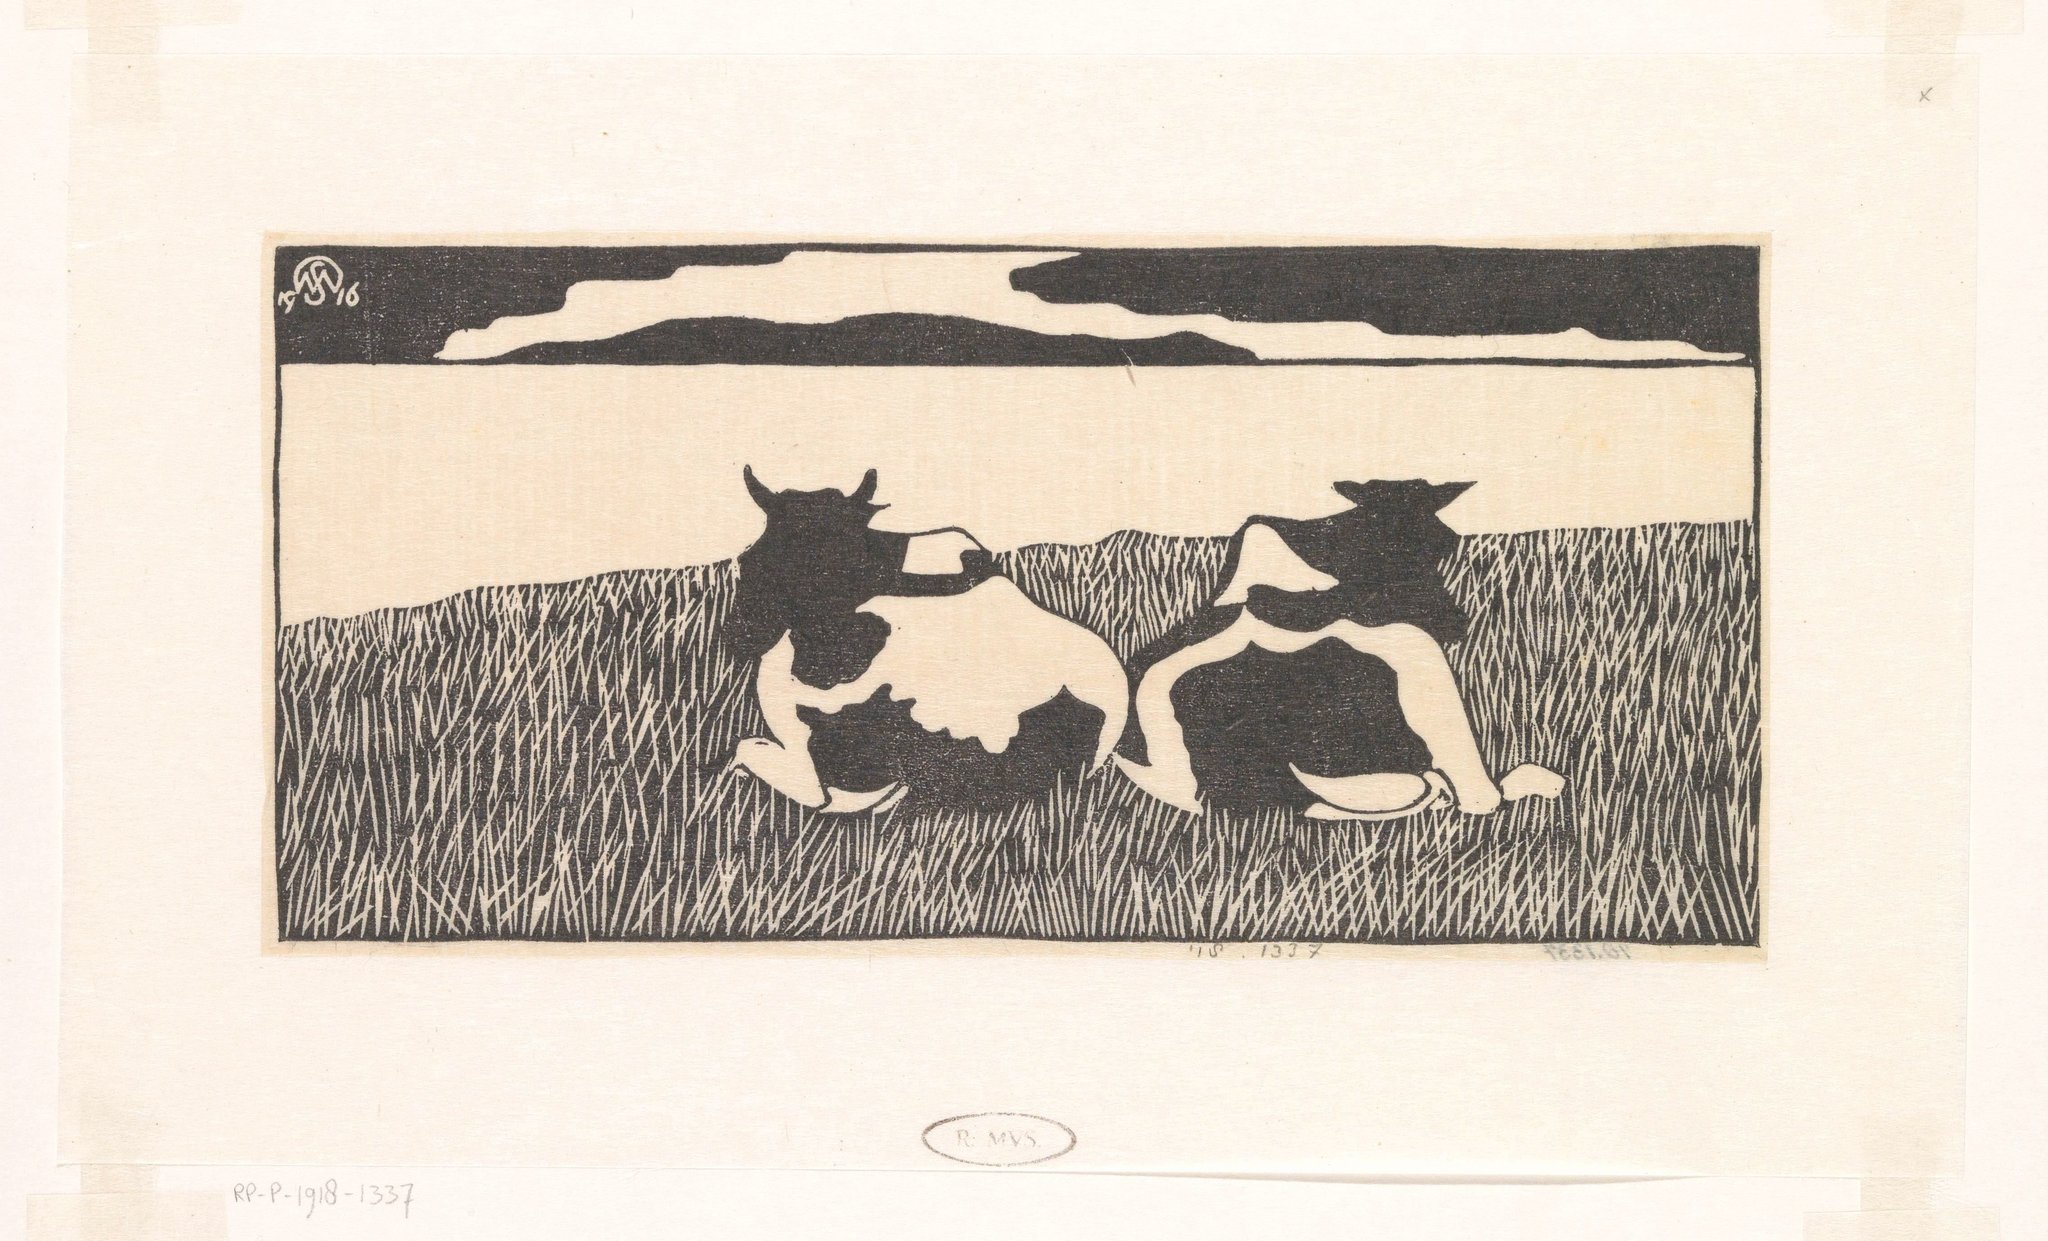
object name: print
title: Koeien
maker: samuel jessurun de mesquita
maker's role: draughtsman, print maker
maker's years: 1868-1944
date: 1916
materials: paper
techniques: woodcut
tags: cow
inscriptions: collector's mark: Lugt 2228